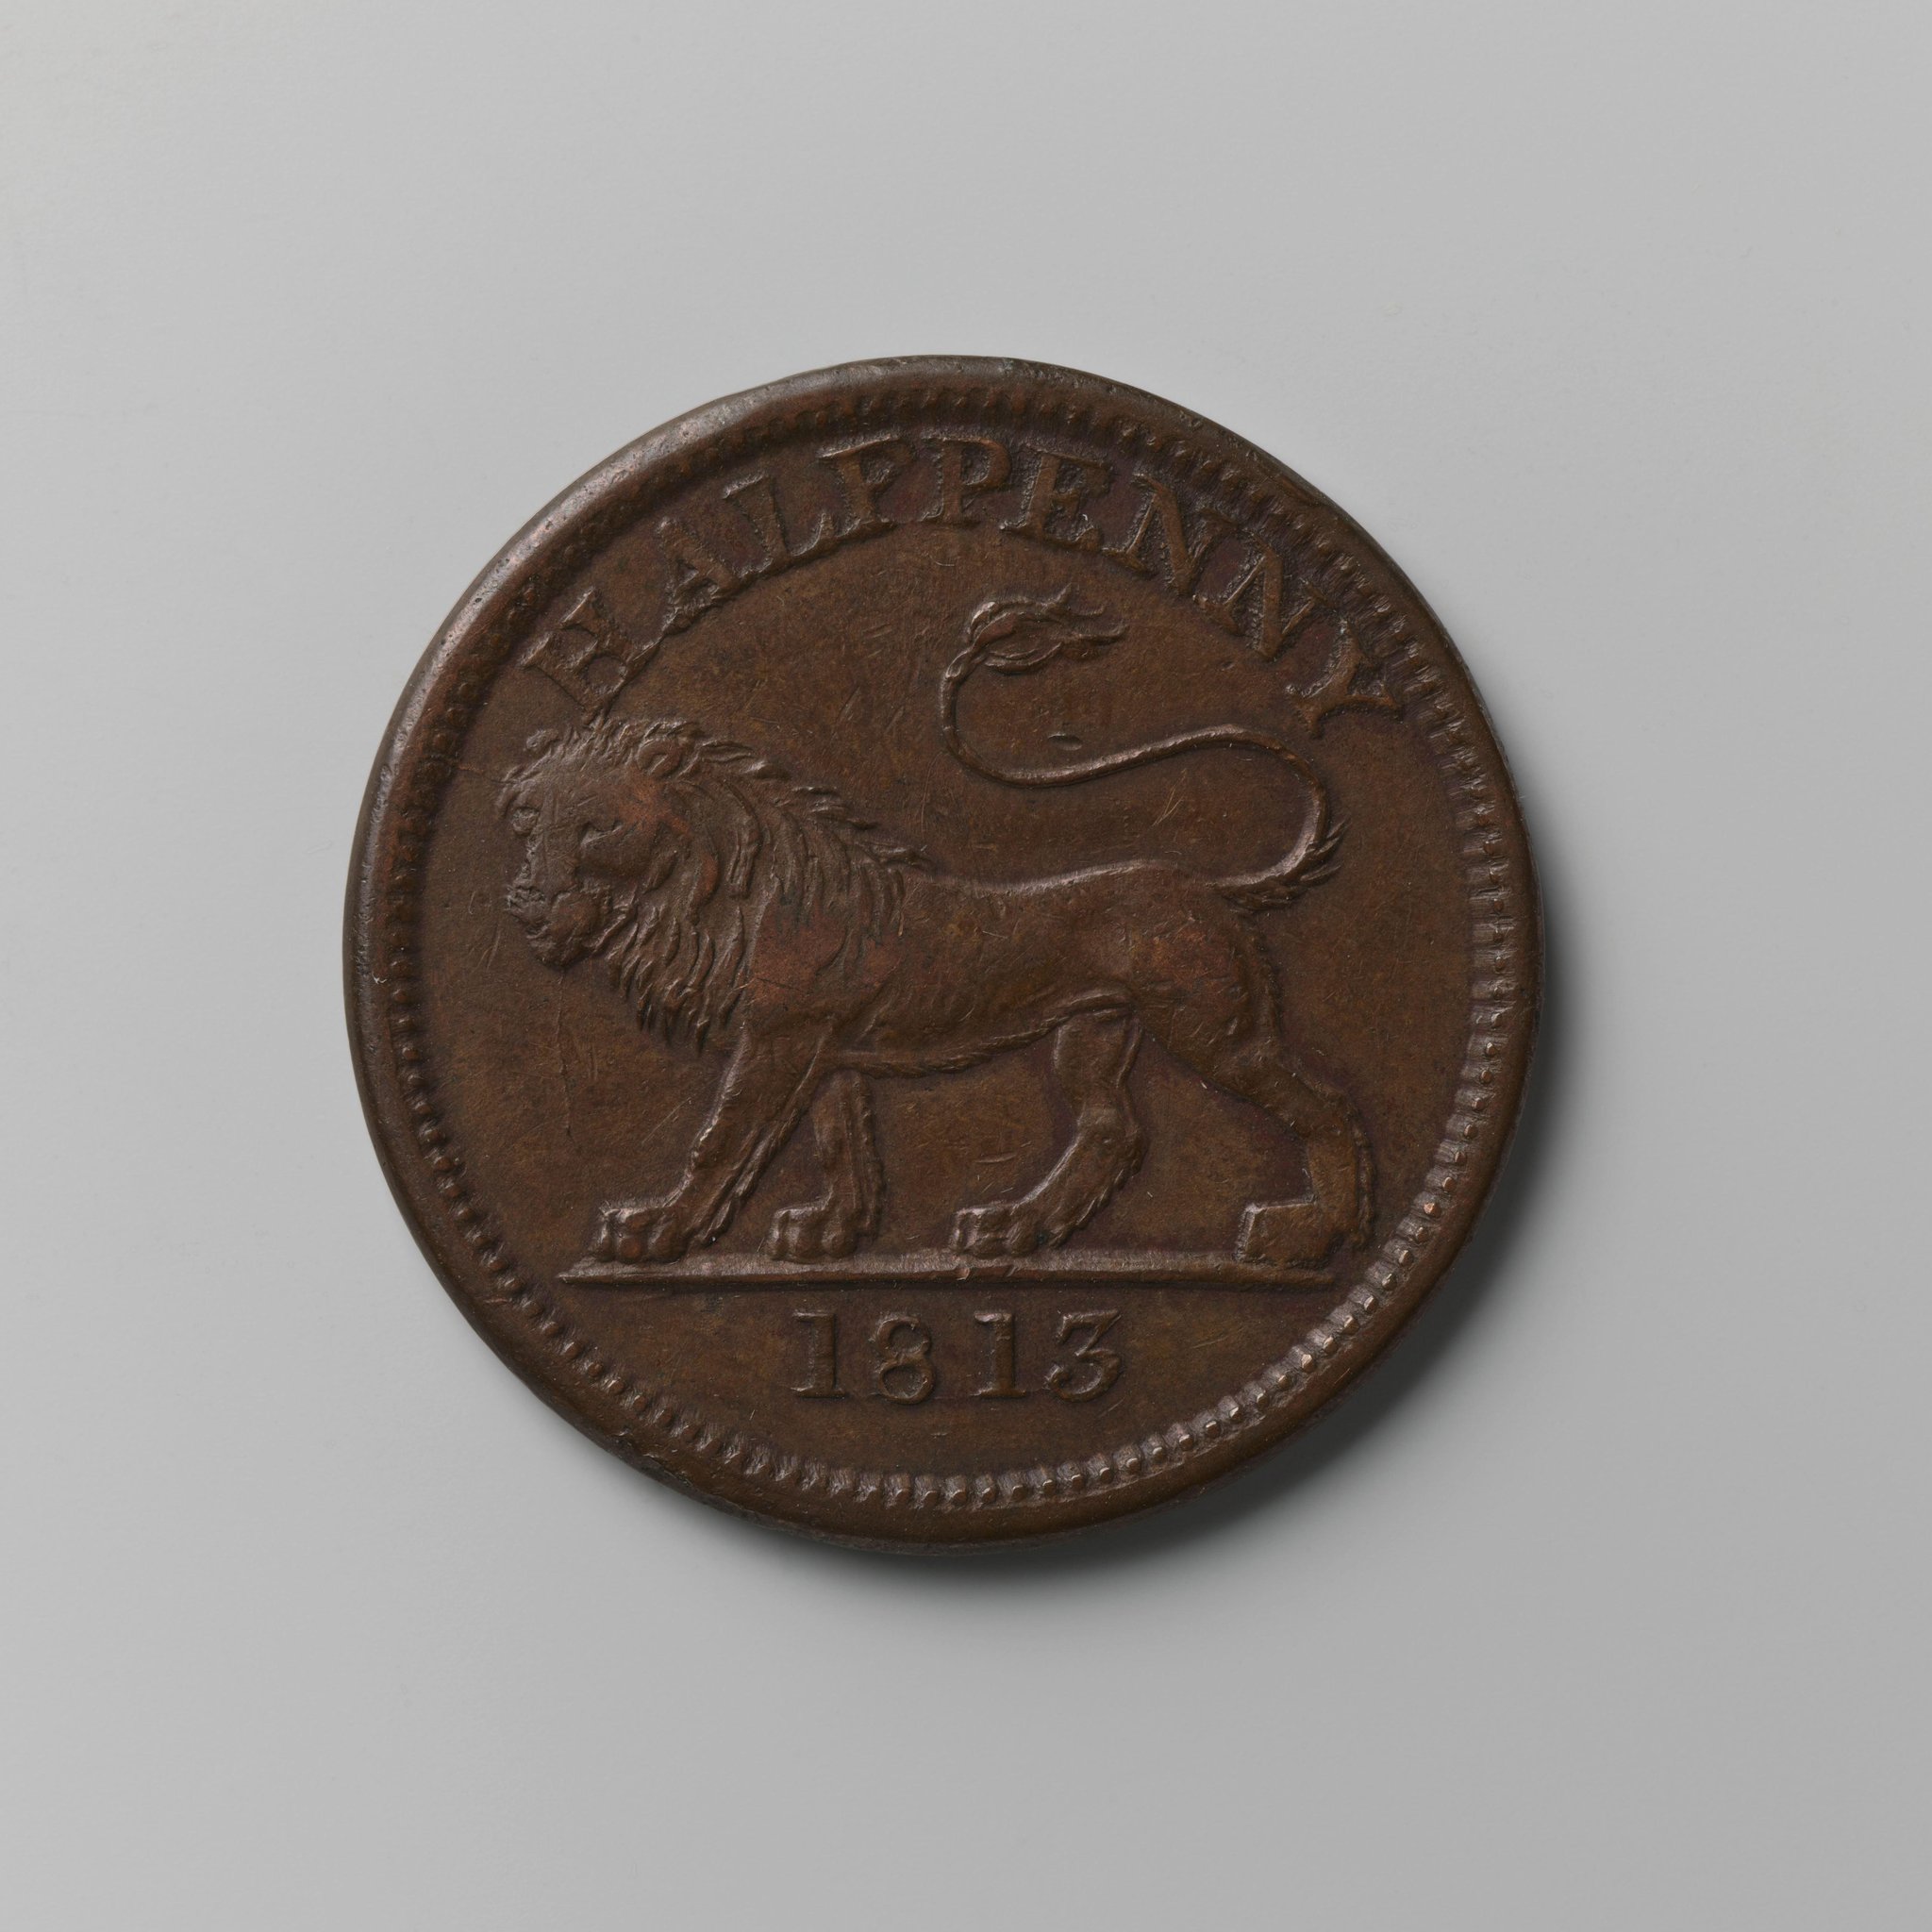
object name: monetary token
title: 1/2 penny-token, Walthamstow, Engeland, 1813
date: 1813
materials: copper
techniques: striking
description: Koperen particuliere munt. Voorzijde: binnen twee samengebonden eiketakken op schild gezeten Brittannnia met drietand en takken, naar links. Keerzijde: gaande leeuw naar links. Daarboven waarde-aanduiding. In afsnede jaartal. Gladde rand.